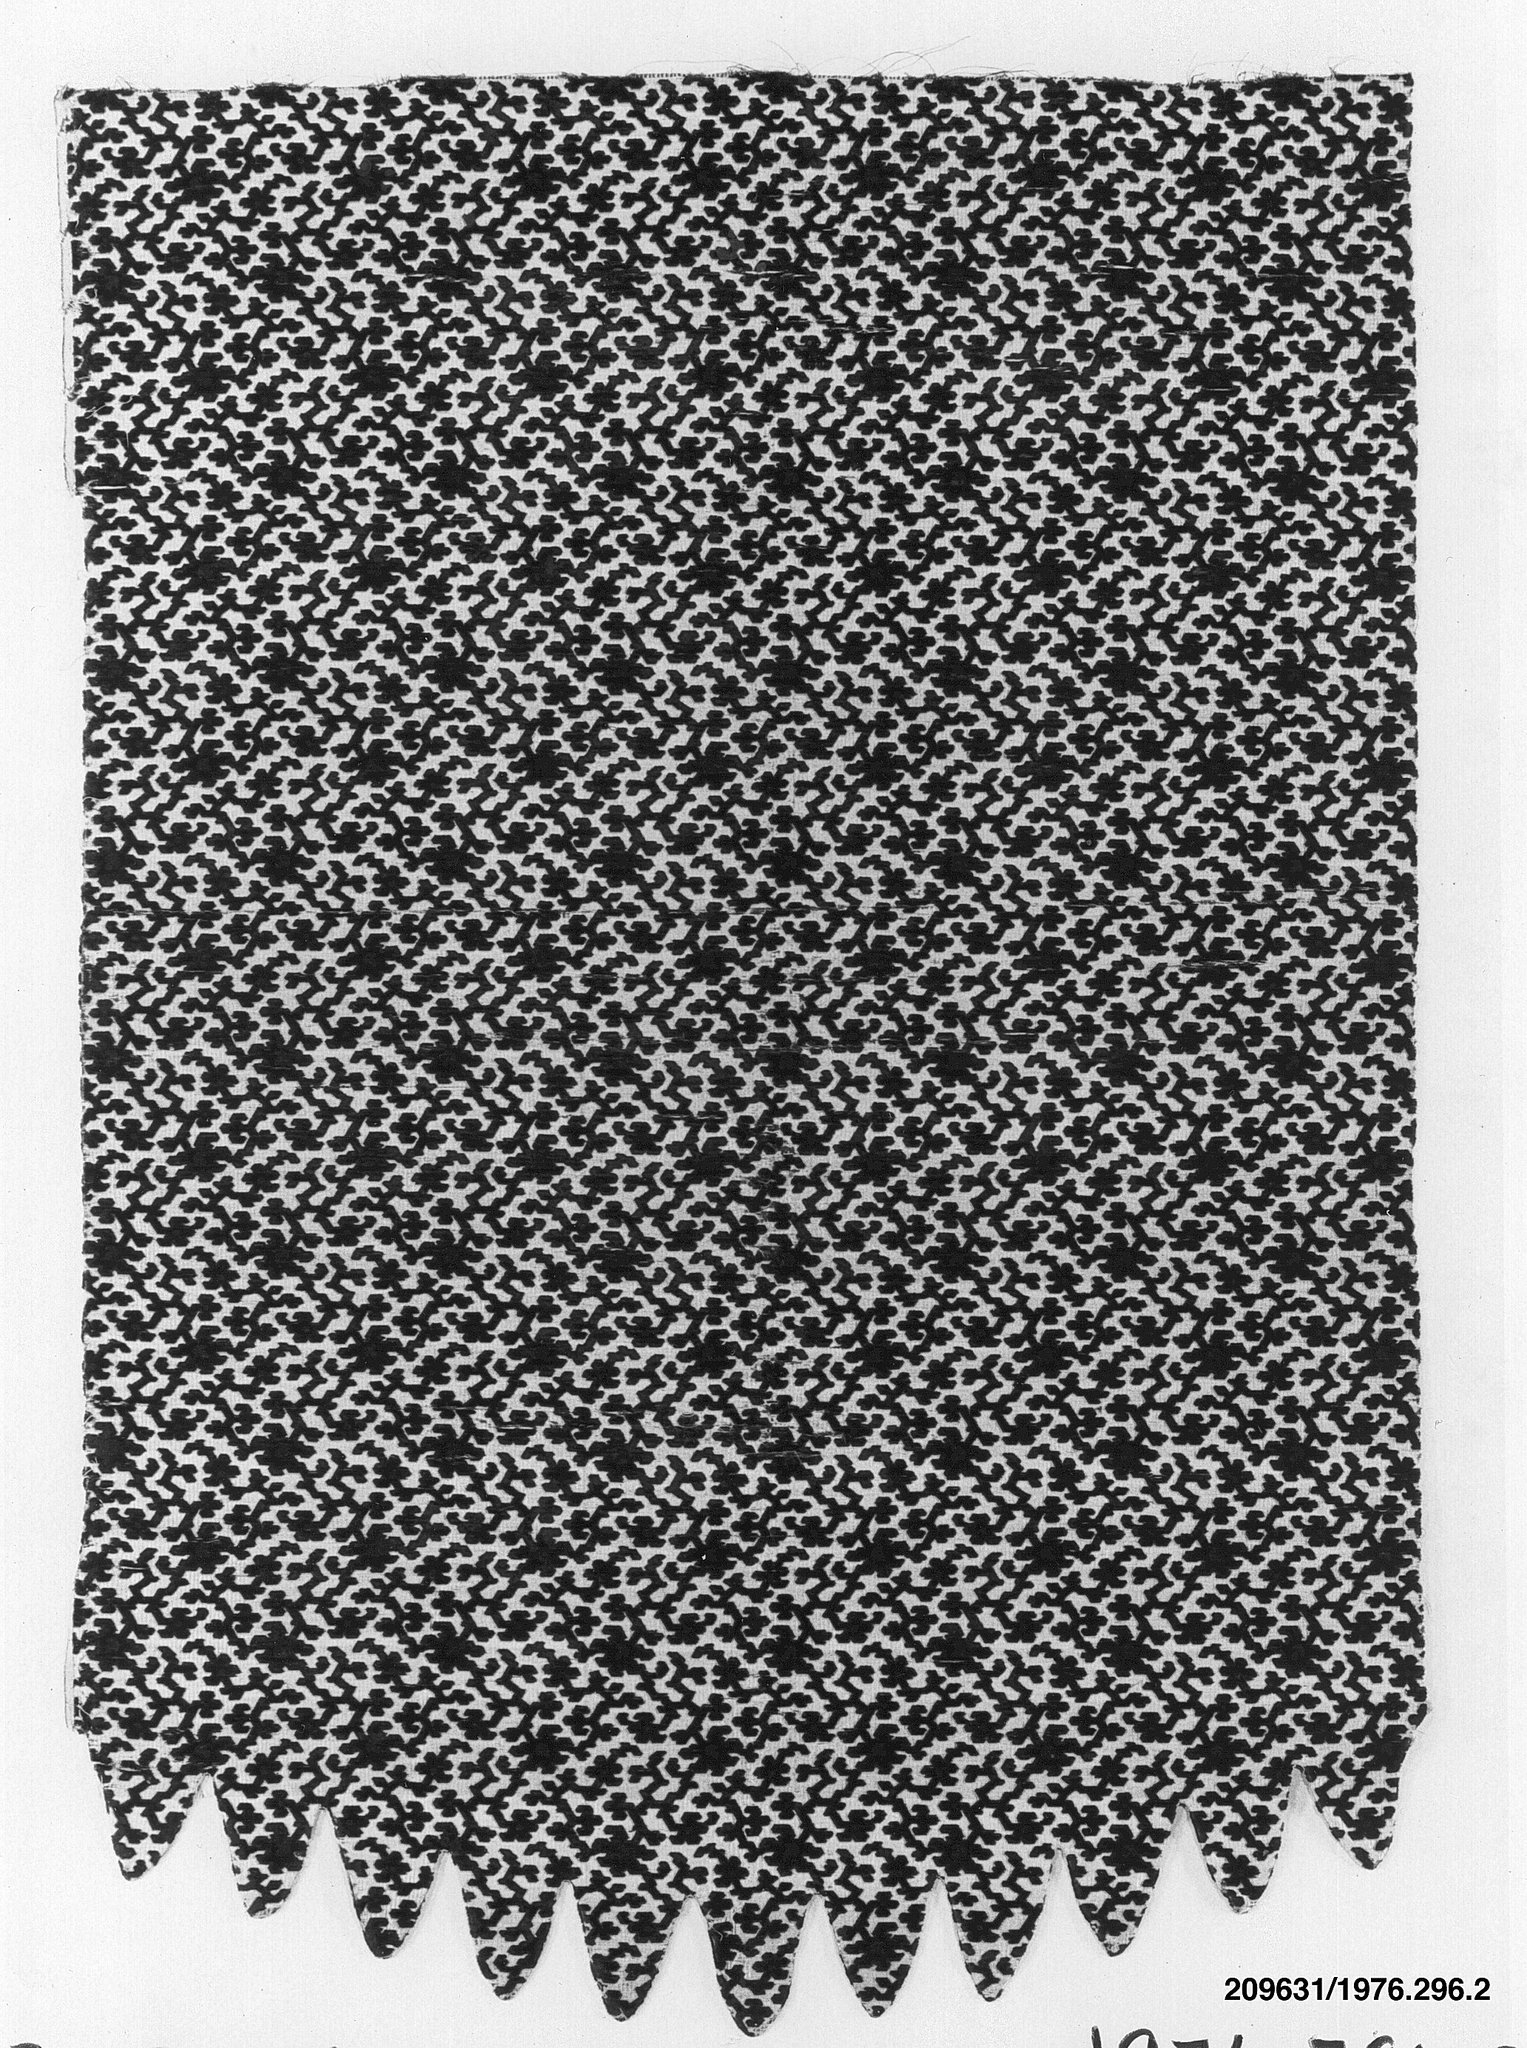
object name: piece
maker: charles frederick worth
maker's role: designer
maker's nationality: french, born england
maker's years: 1825-1895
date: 1880-1889